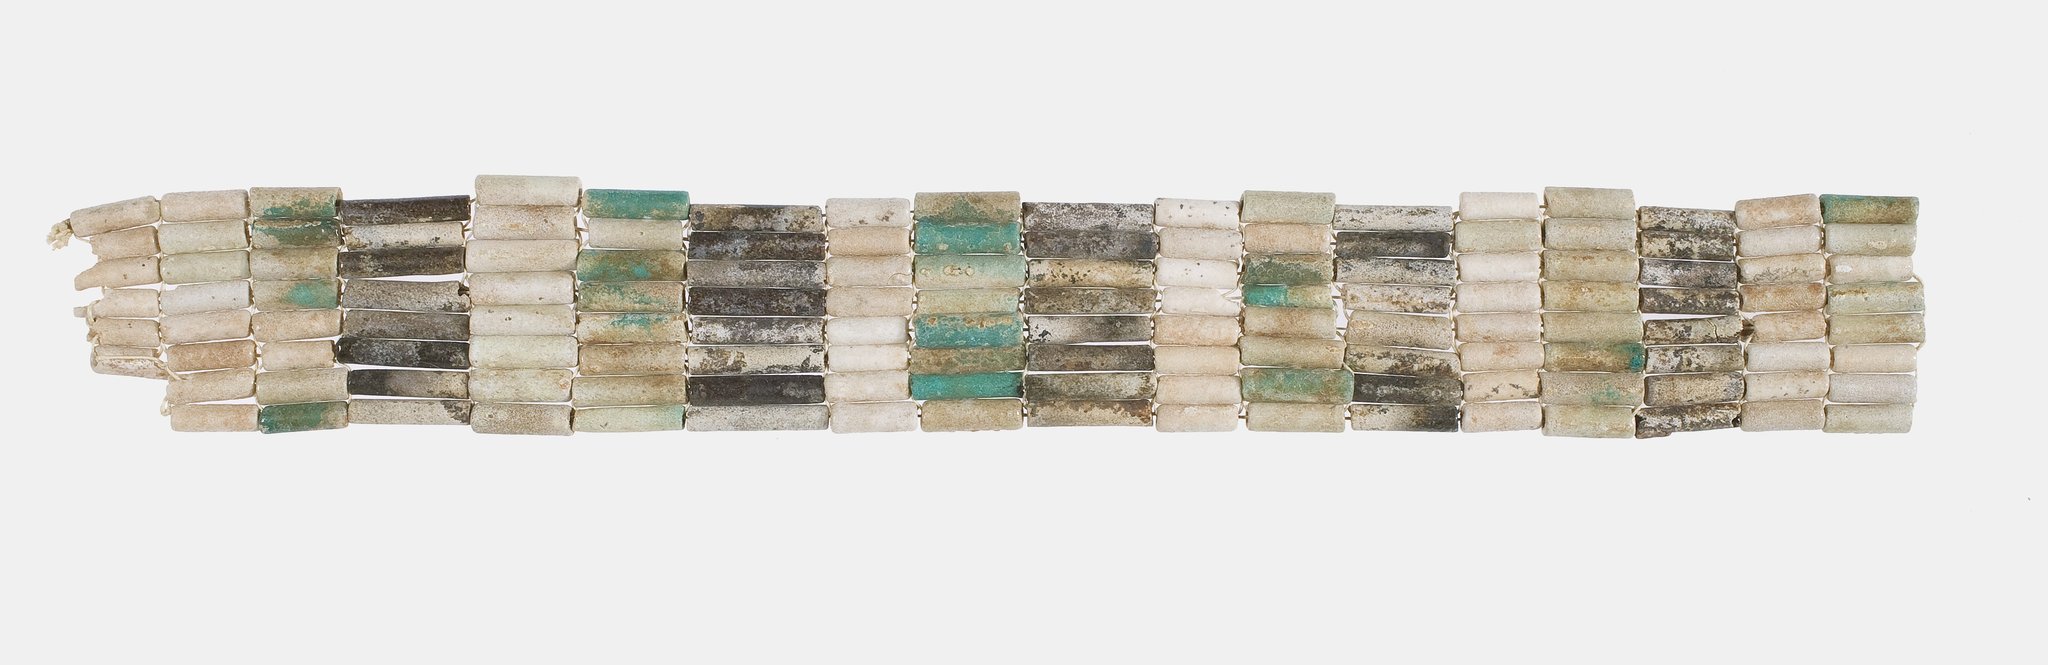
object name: bracelet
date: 1981-1640 BCE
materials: faience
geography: egypt